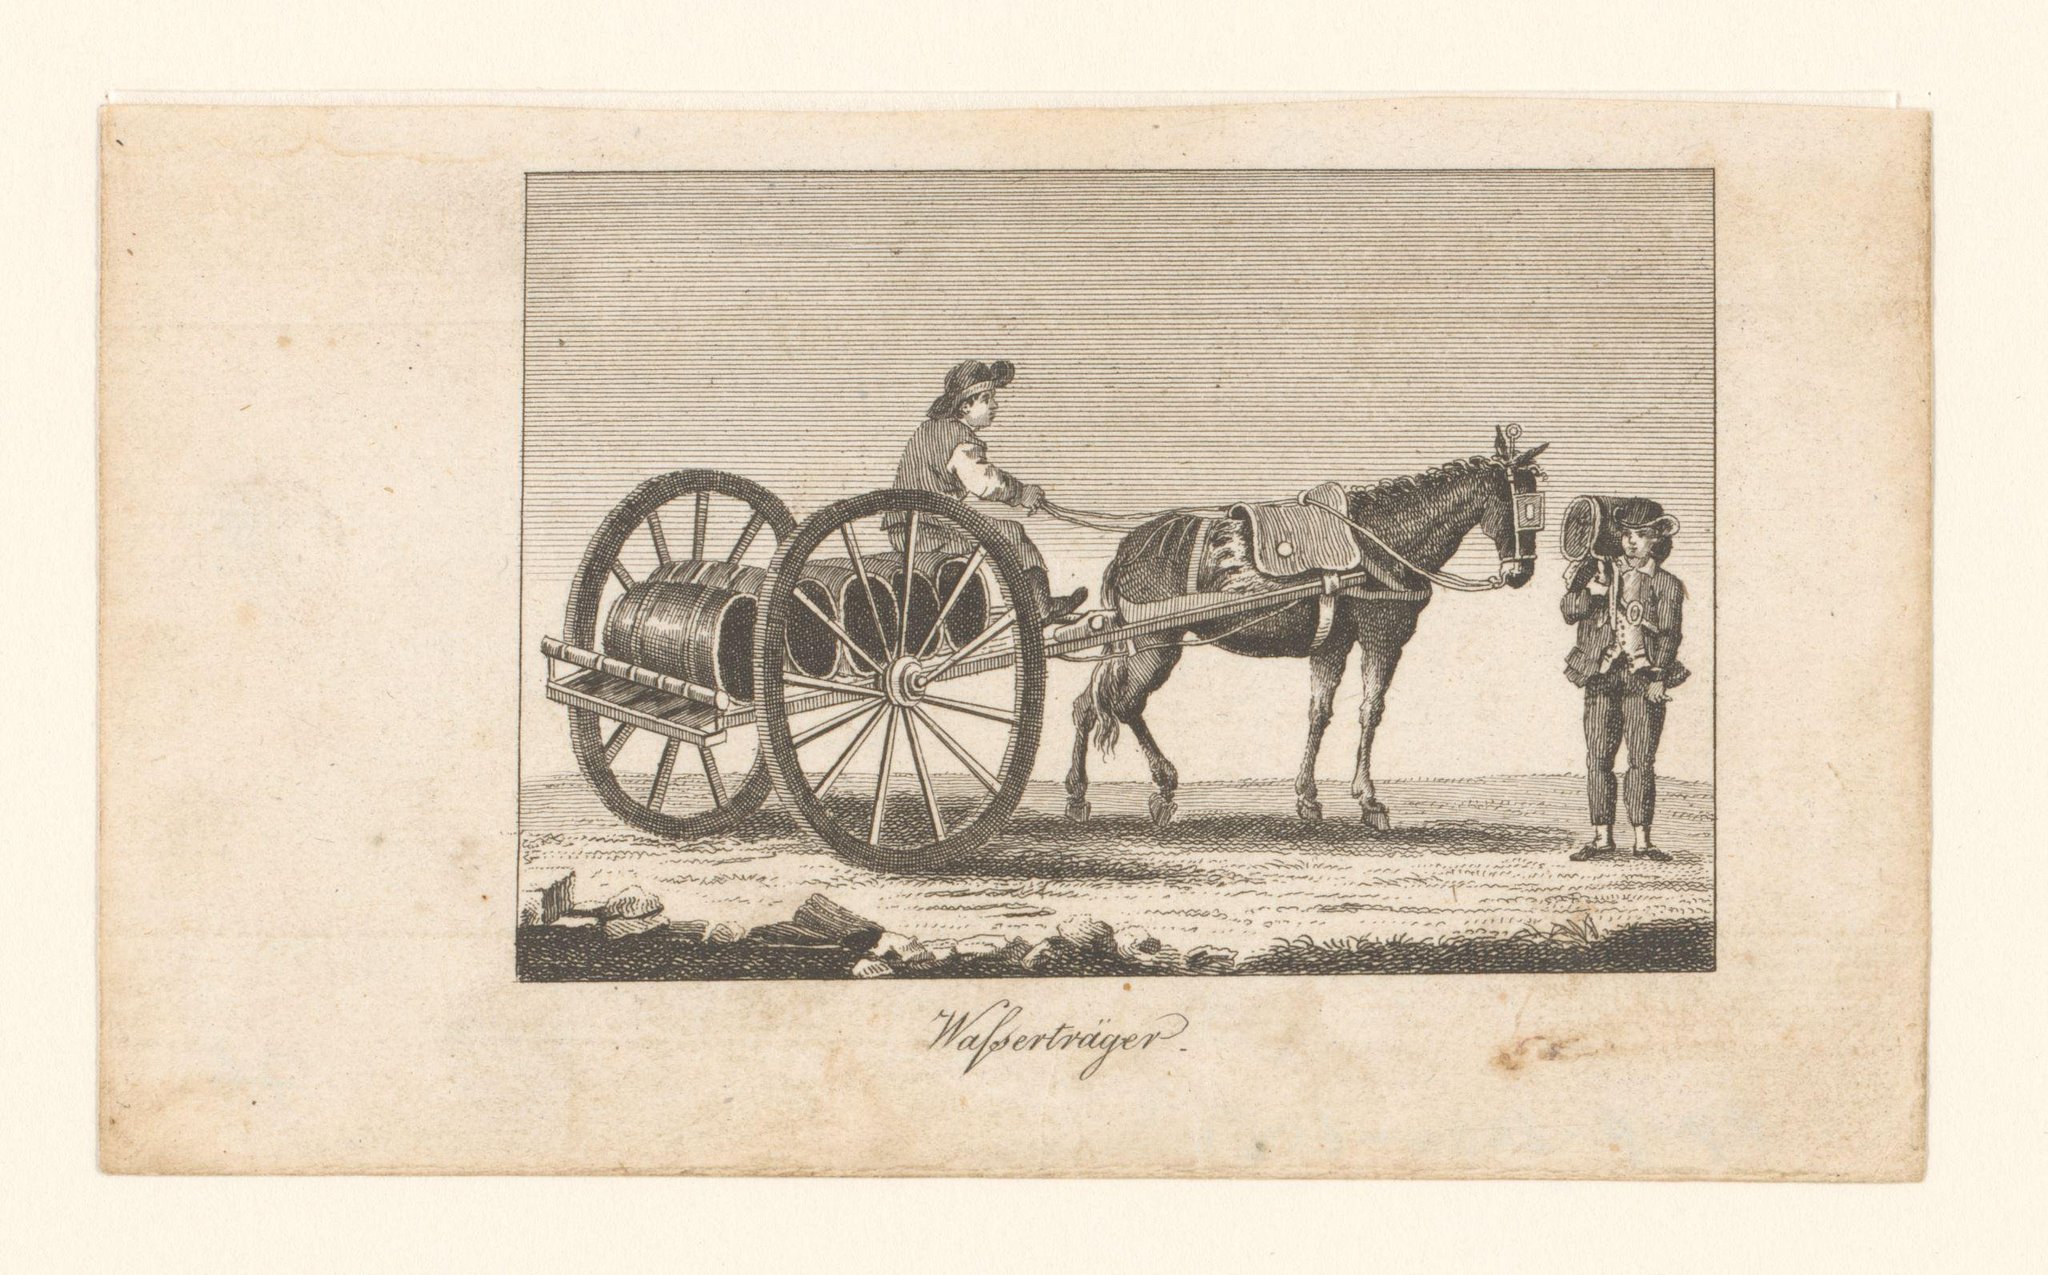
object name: print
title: Waterdrager op paard en wagen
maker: Anonymous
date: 1700-1799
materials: paper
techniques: etching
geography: germany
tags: wooden container: barrel, cask, bucket, two-wheeled vehicle drawn by one animal